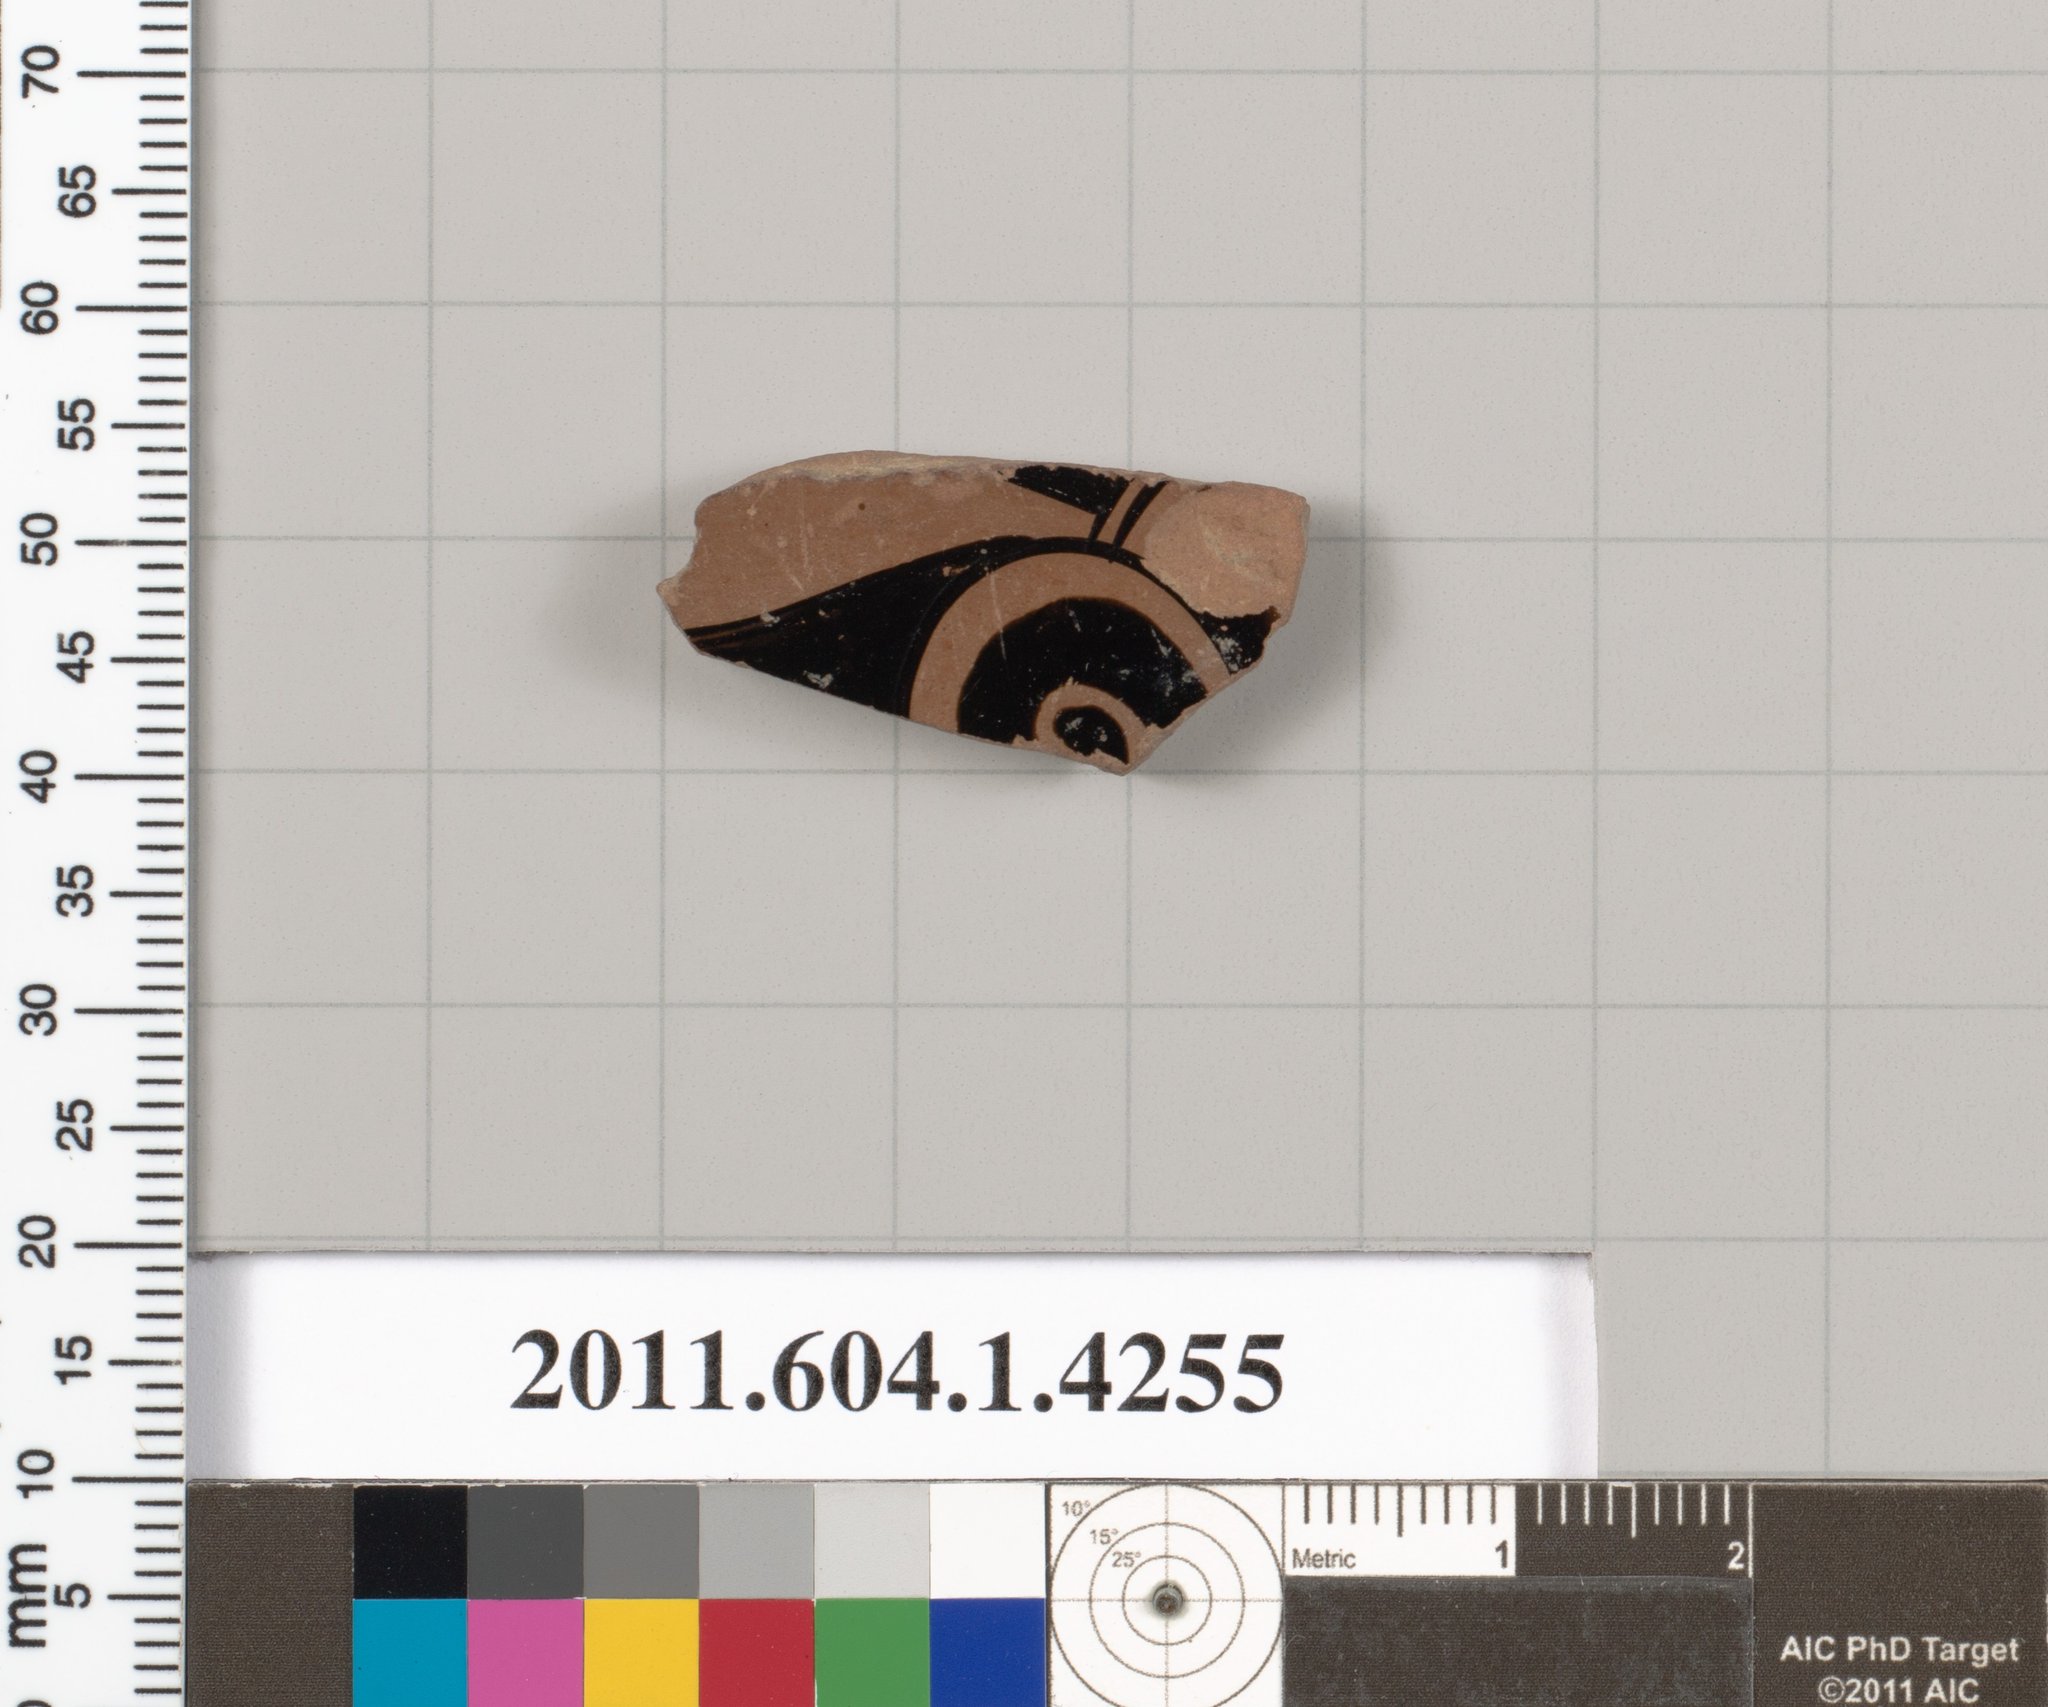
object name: kylix fragment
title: Terracotta fragment of a kylix (drinking cup)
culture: greek, attic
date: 500-476 BCE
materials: terracotta